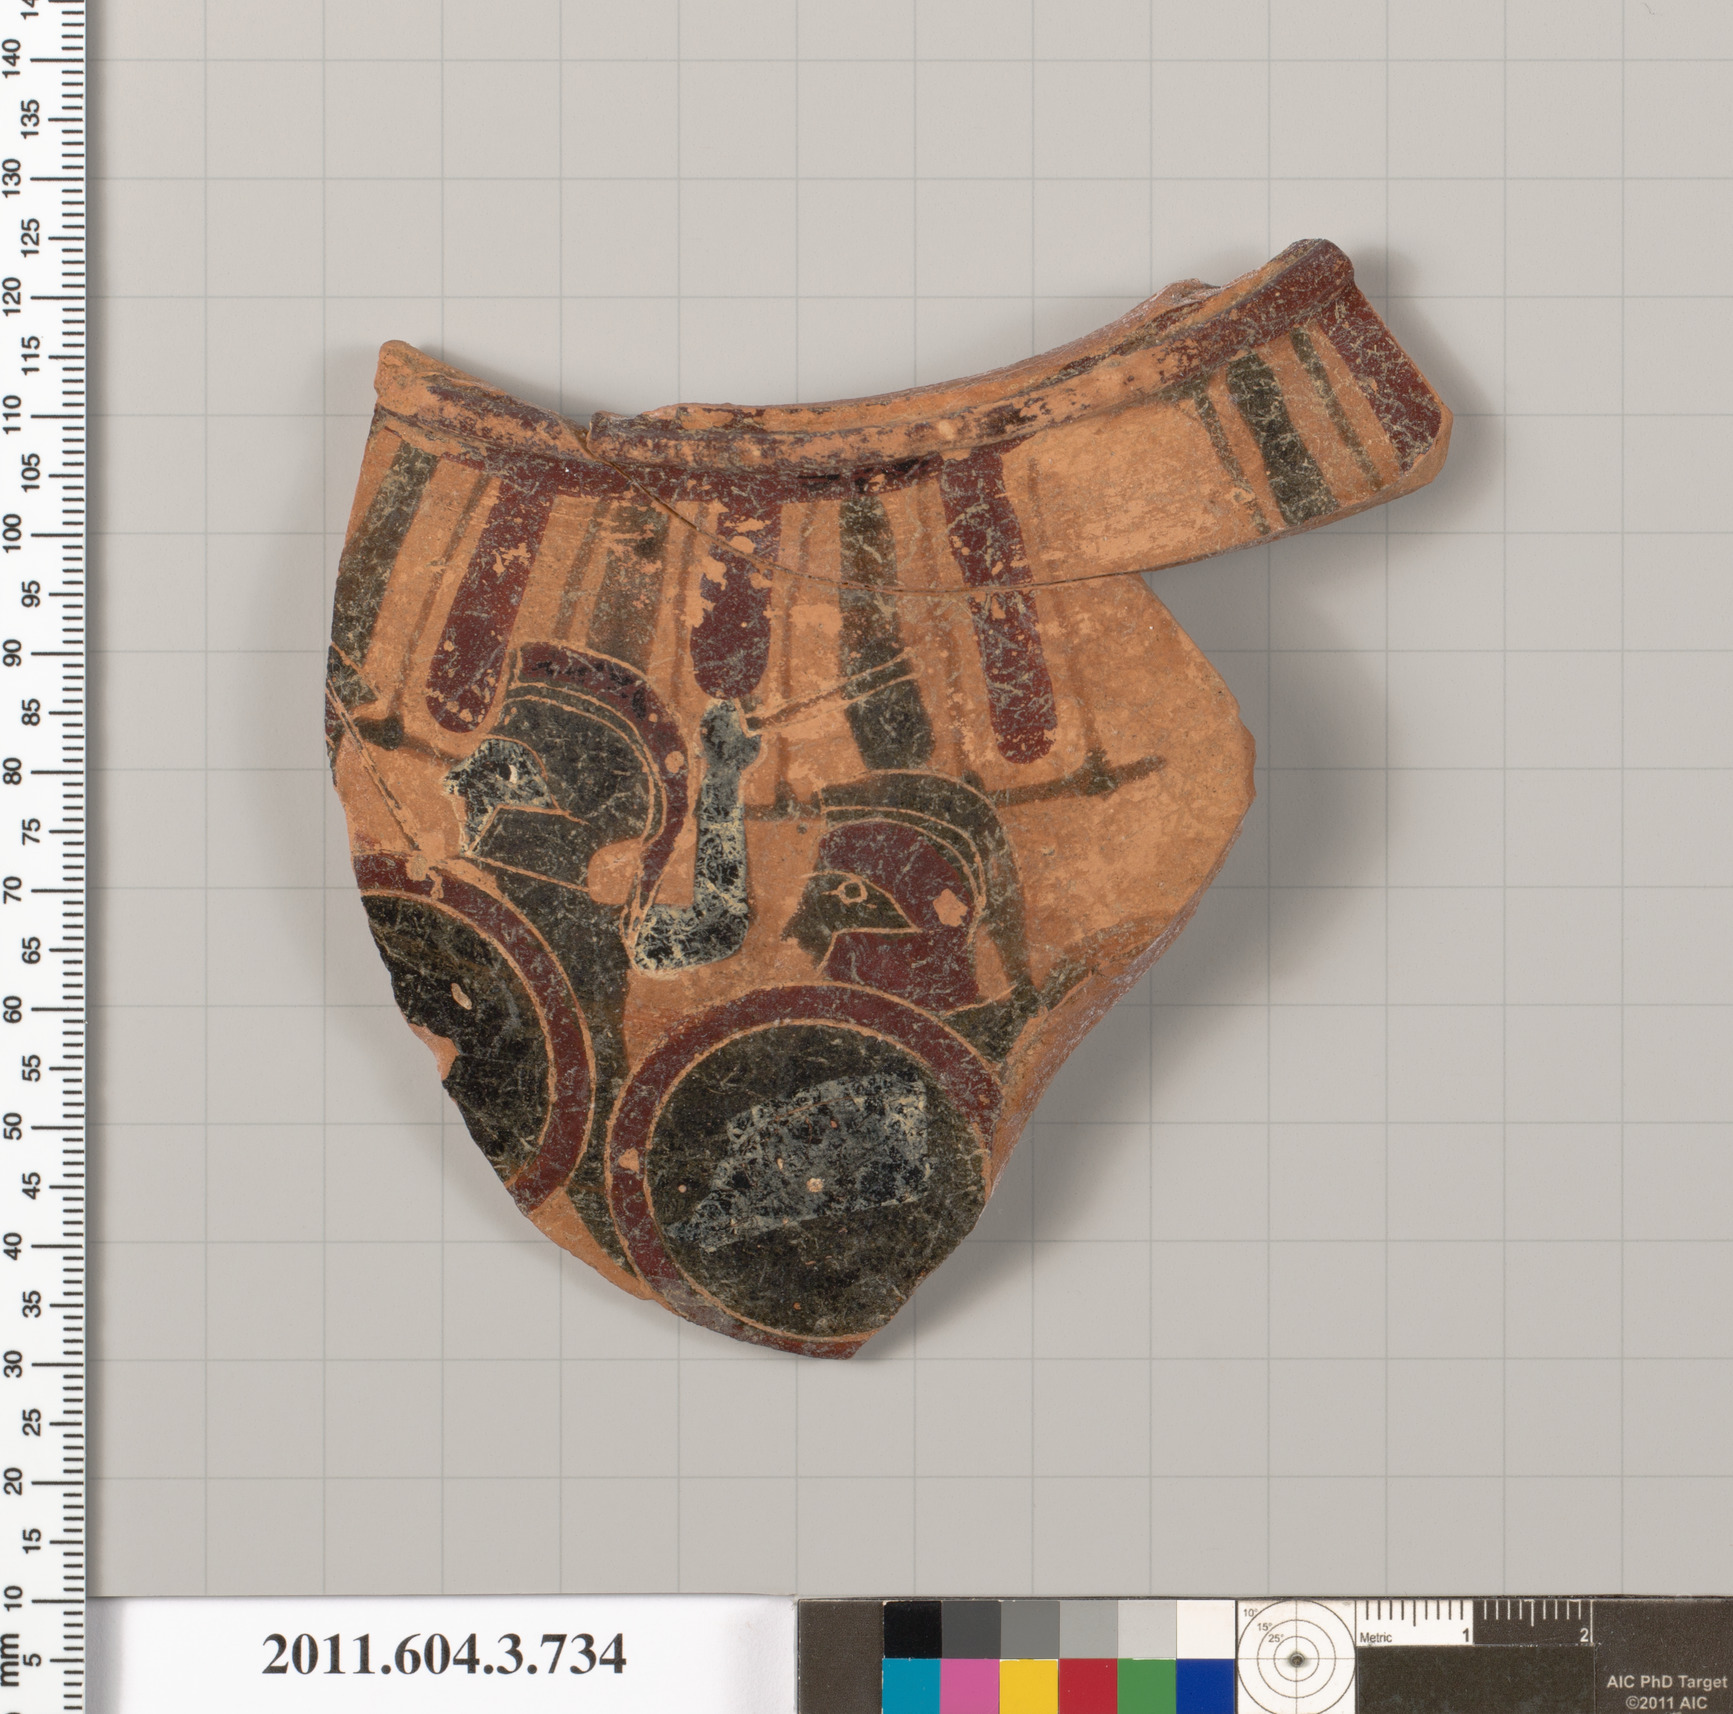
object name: neck amphora, tyrrhenian fragment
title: Terracotta fragment of a neck-amphora (jar)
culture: greek, attic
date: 570-560 BCE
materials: terracotta